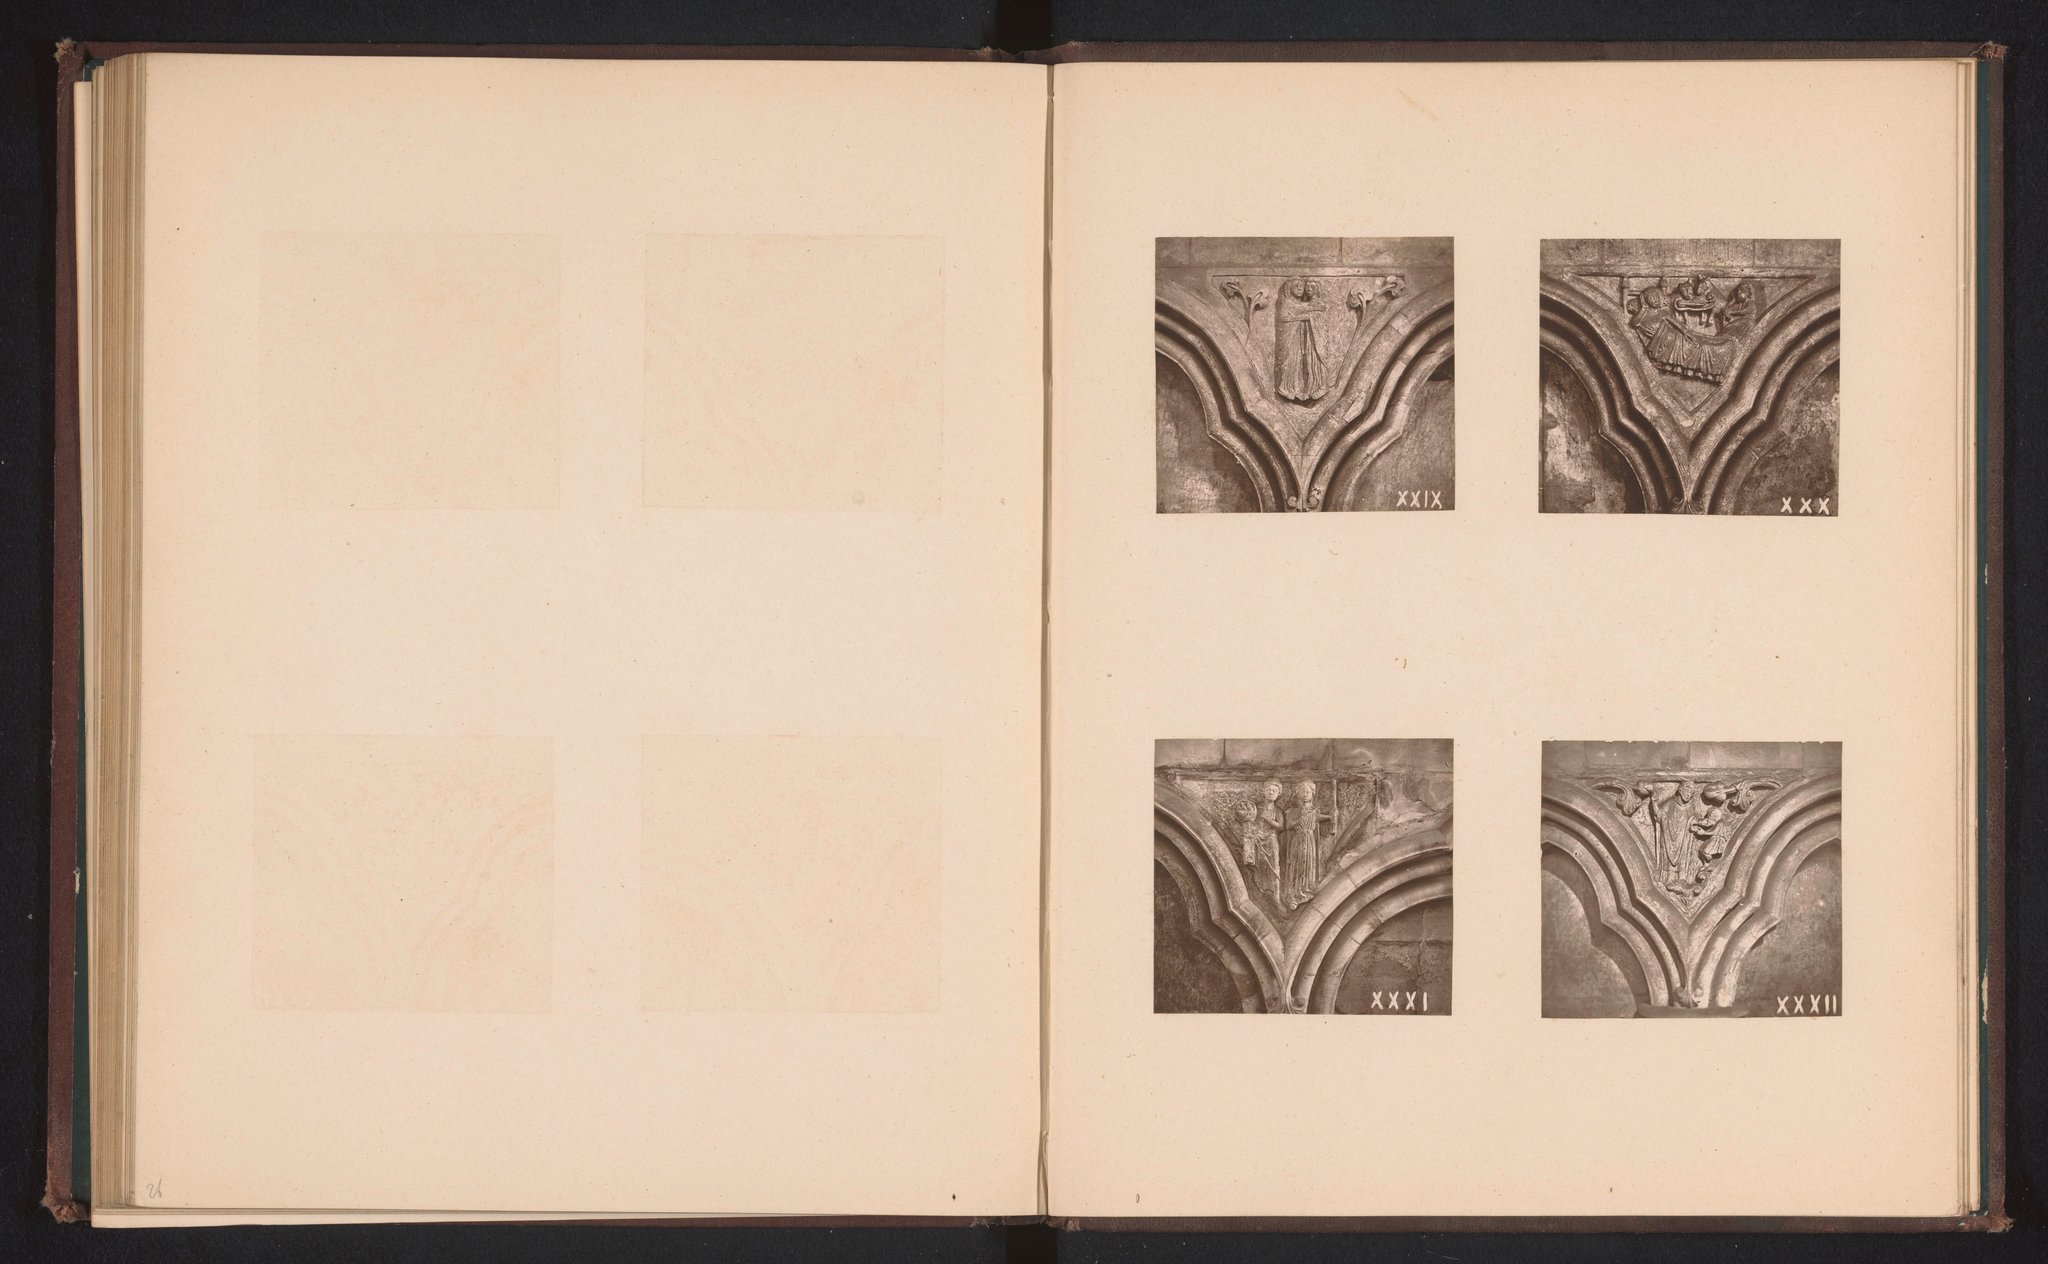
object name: page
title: Vier houtsnijwerken in een arcade van de Kathedraal van Worcester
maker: Anonymous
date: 1863-1873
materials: paper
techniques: woodburytype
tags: carving ~ applied arts, mary and elisabeth, both pregnant, embracing, story of the birth of christ (luke 2:1-20), interior of church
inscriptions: number: ‘XXIX (...) XXXII’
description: Linksboven de ontmoeting van Maria en Elisabeth, rechtsboven de geboorte van Christus, linksonder twee vrouwen, rechtsonder een monnik kastijdt een schooljongen.